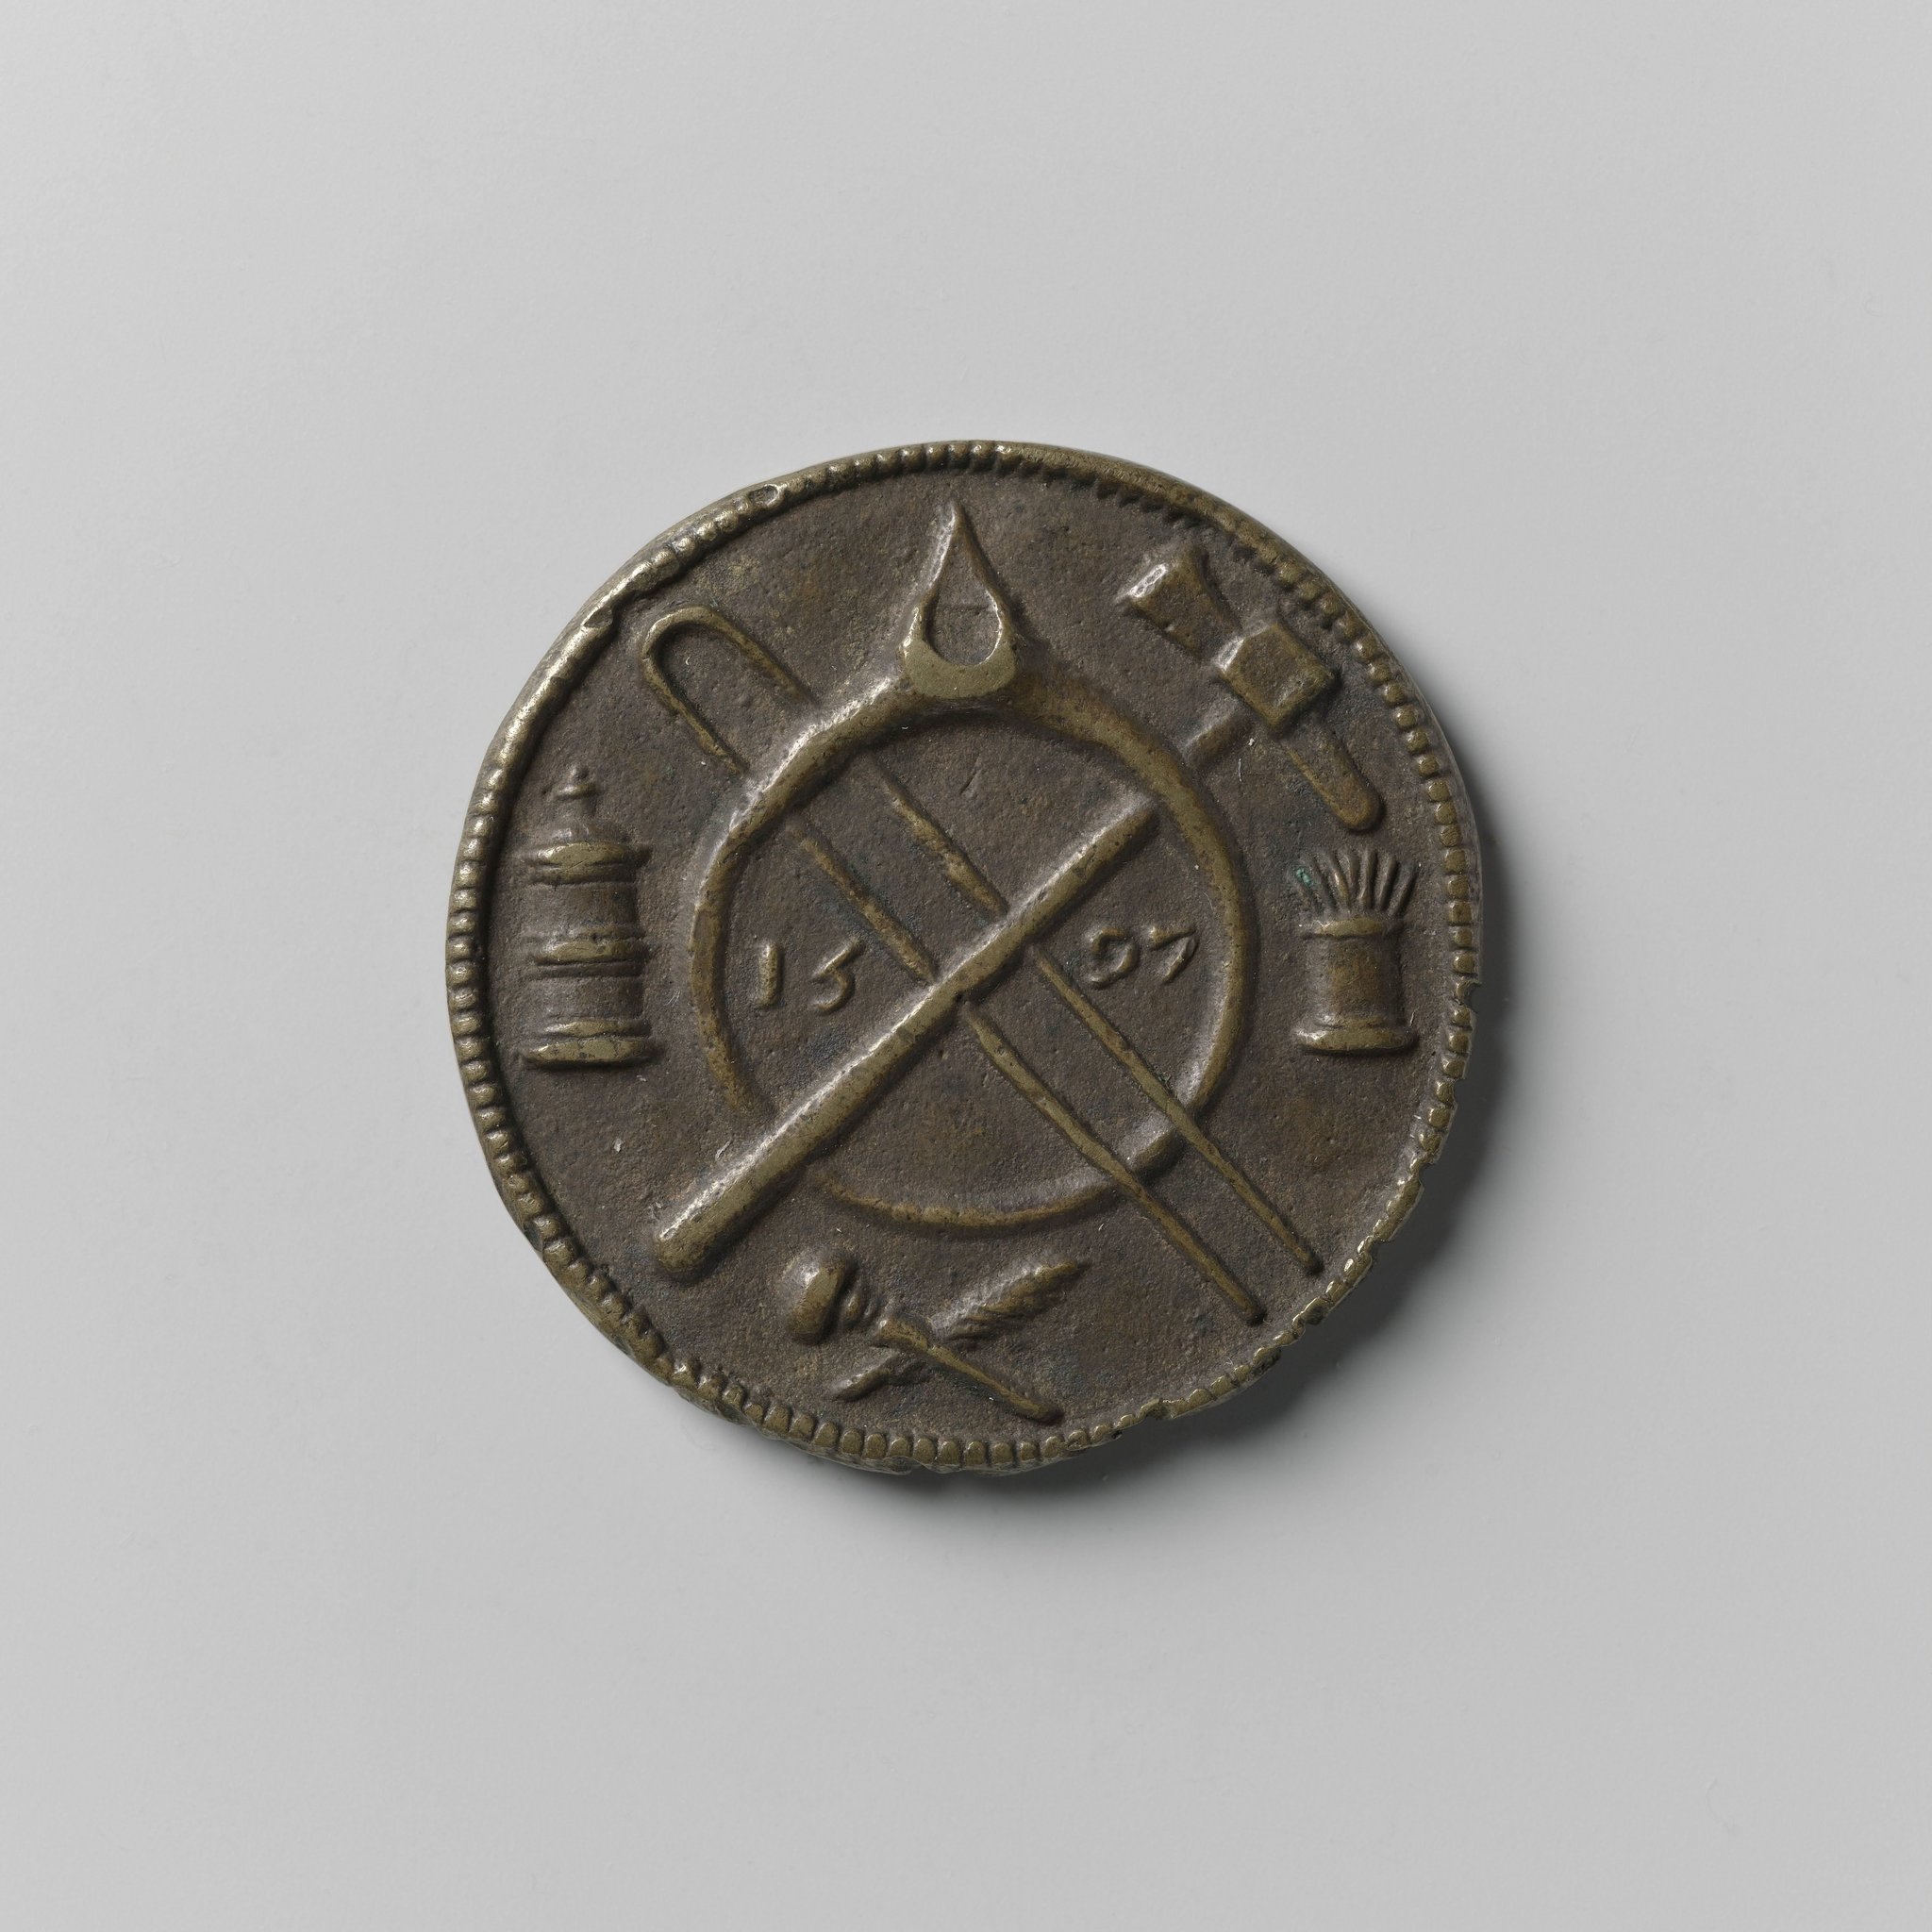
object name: medal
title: Scheepmakersgilde van Vlissingen, gildepenning met no. 90 en 41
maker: Anonymous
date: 1623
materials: lead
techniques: casting, engraving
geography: flushing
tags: flushing